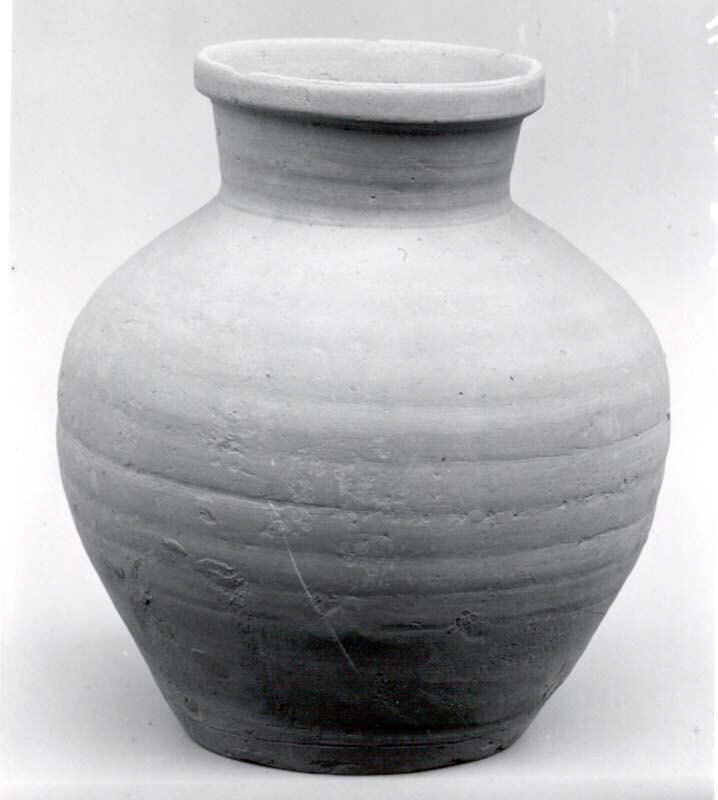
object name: jar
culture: sasanian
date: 501-700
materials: ceramic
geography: iran